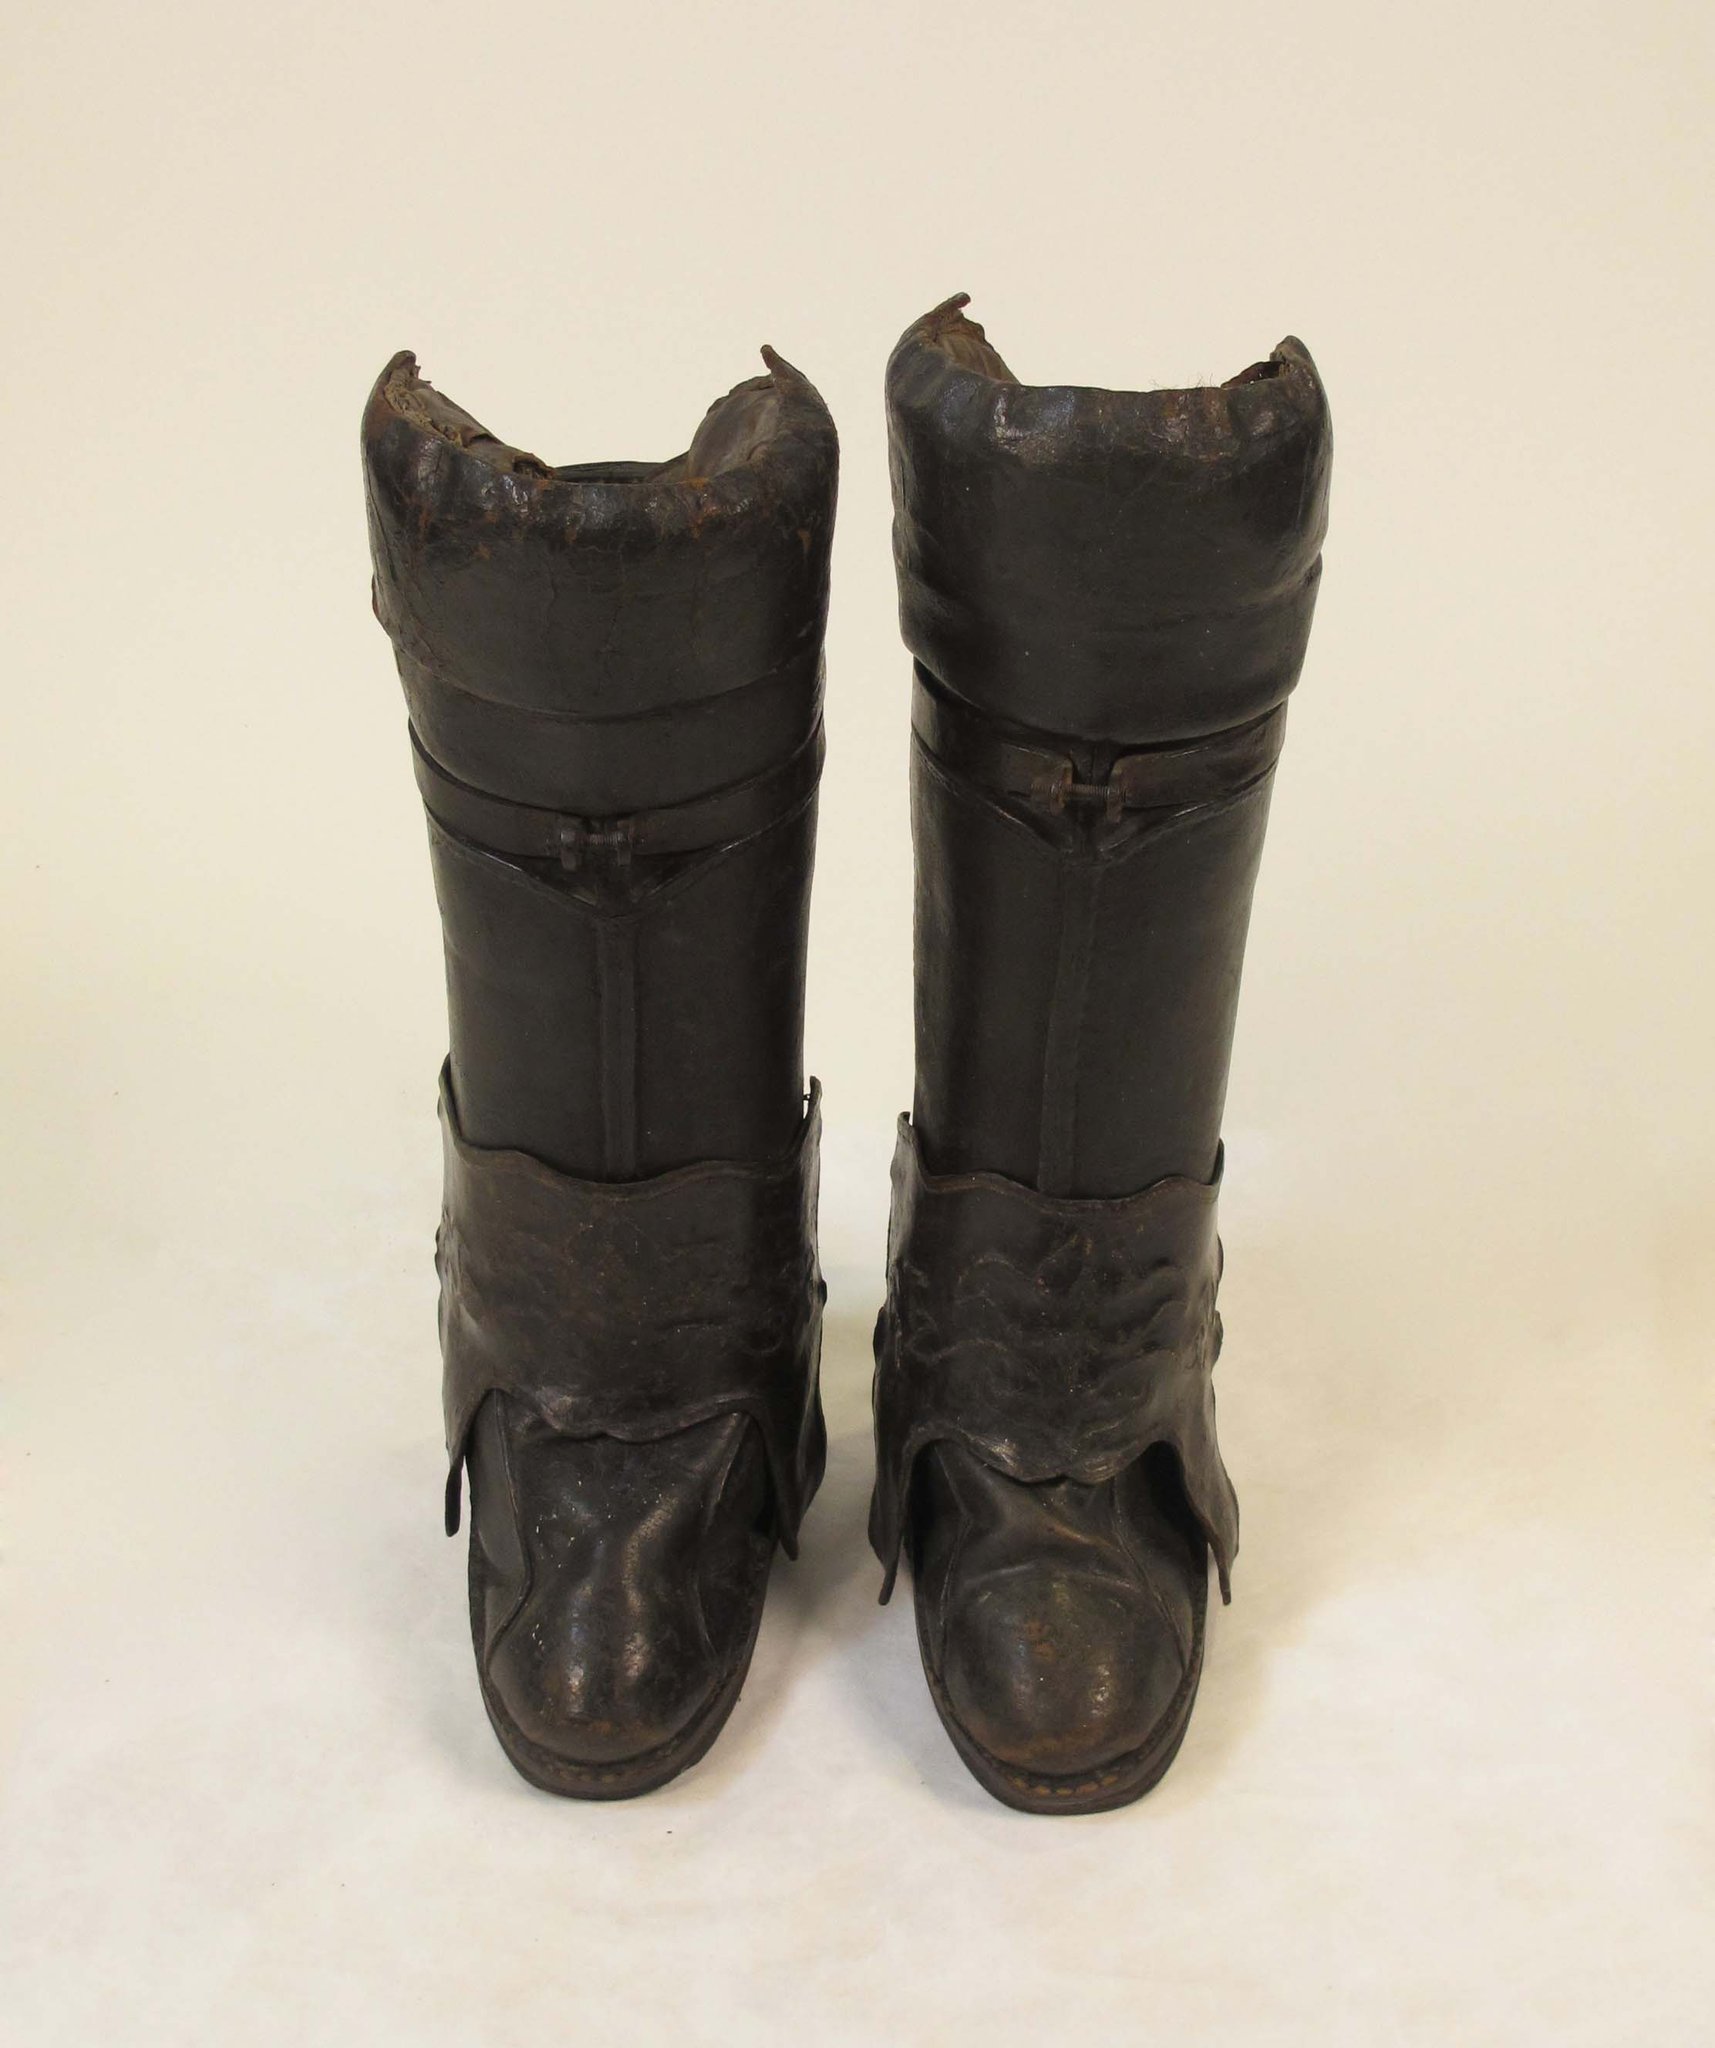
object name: boot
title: Boots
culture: french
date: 1701-1733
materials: hair, leather, metal